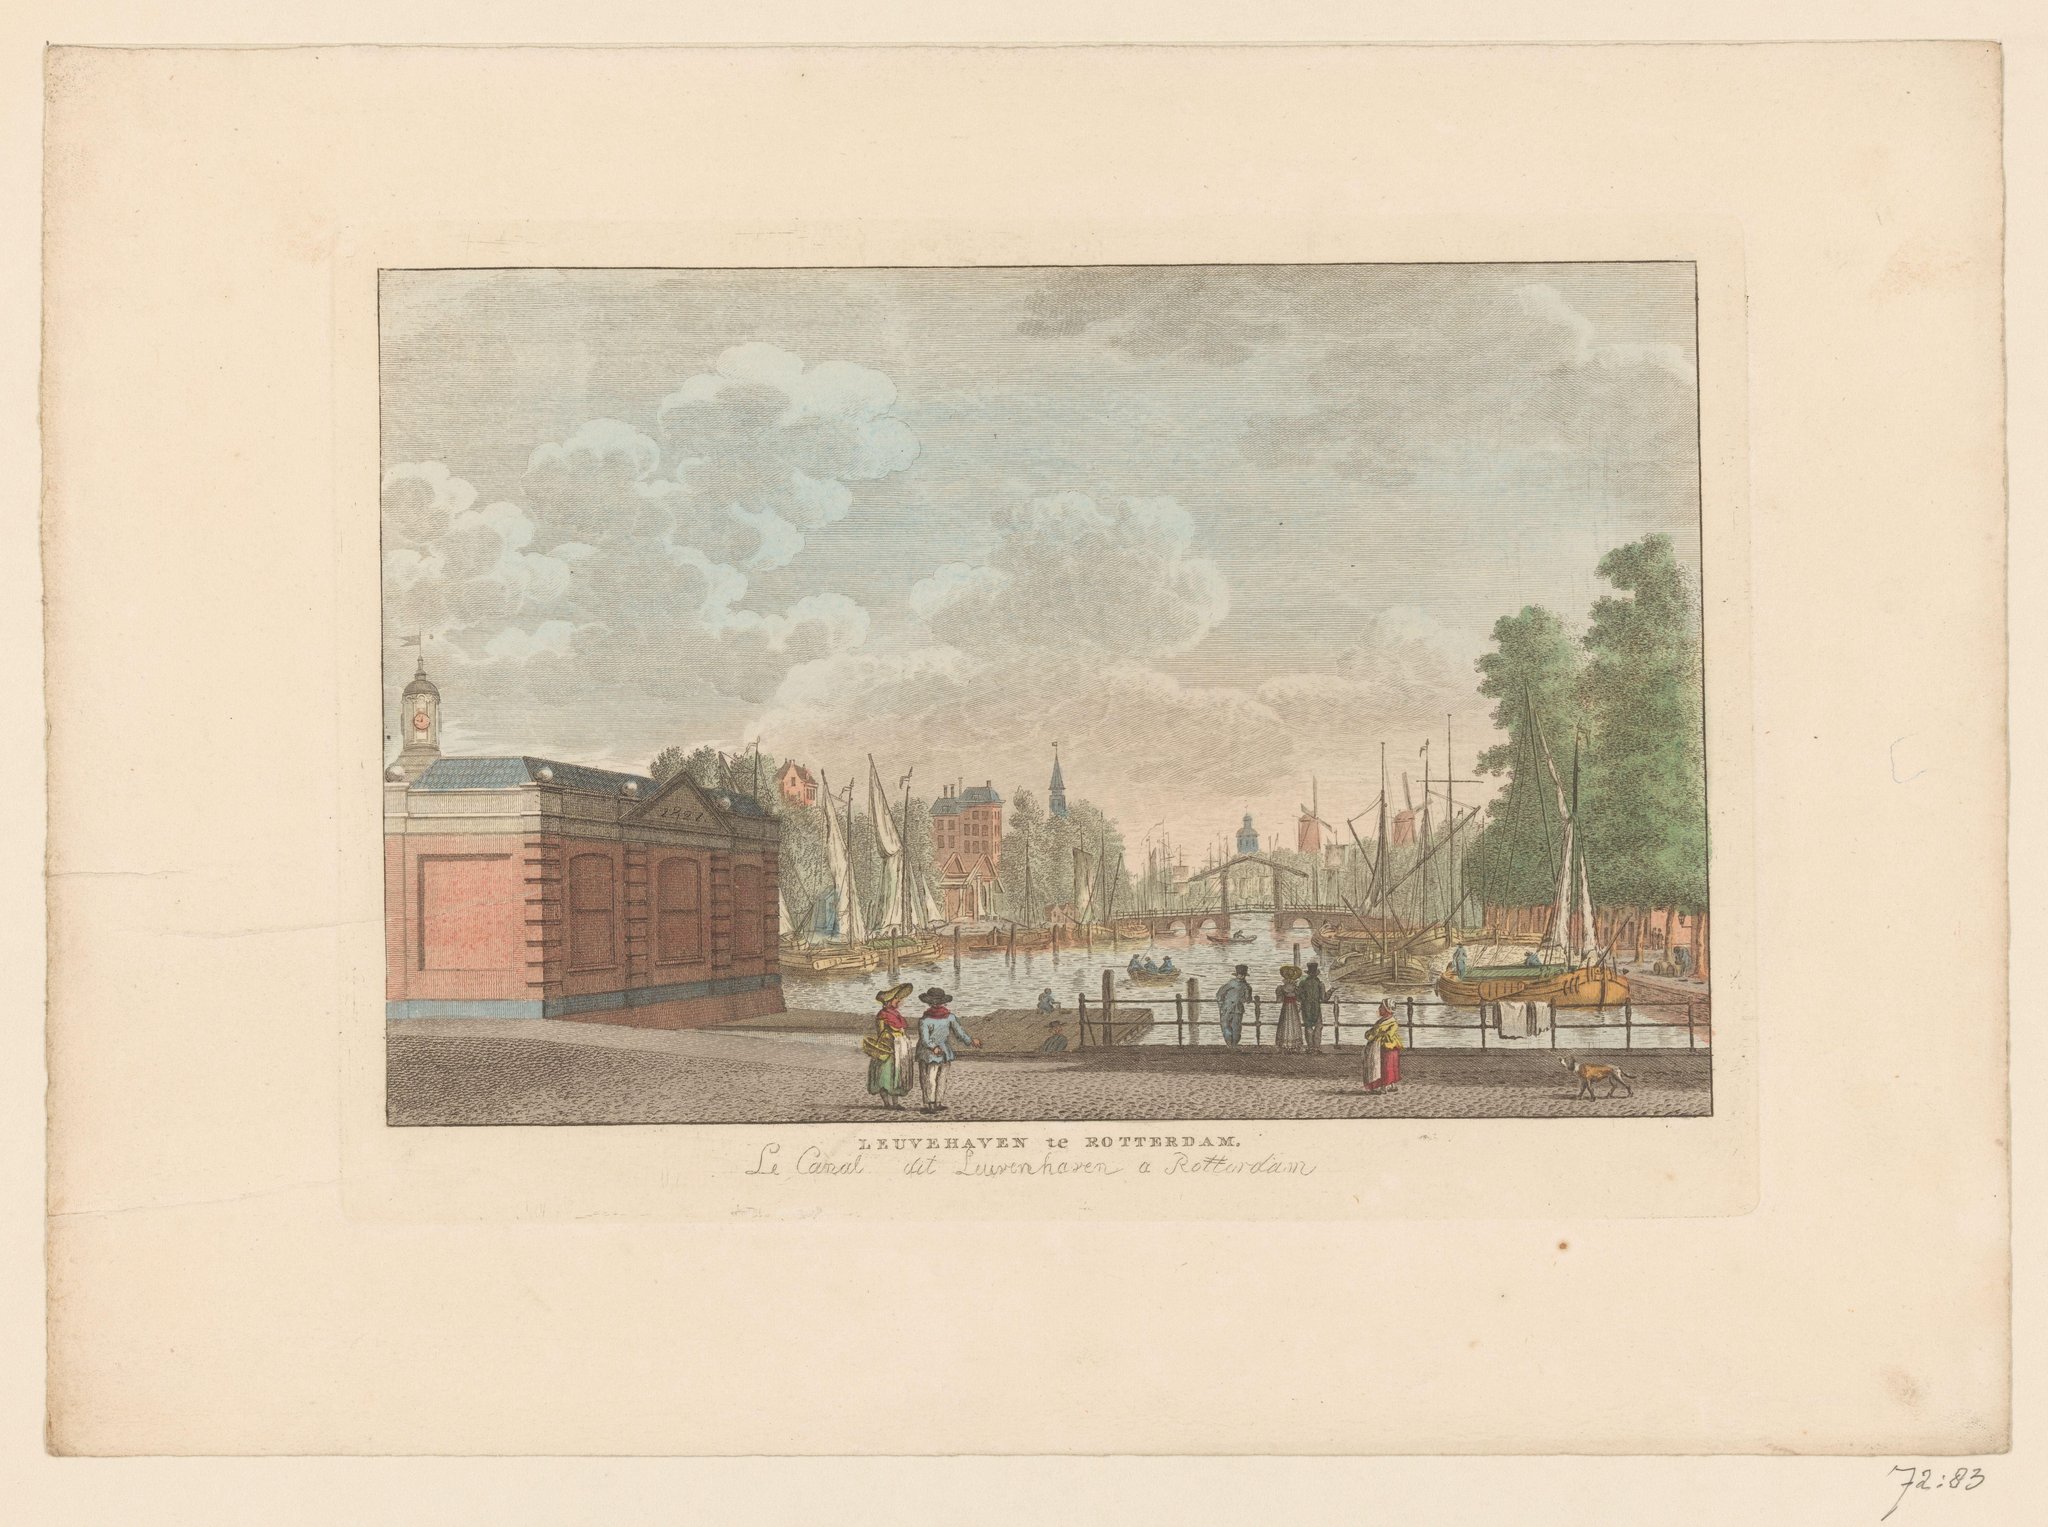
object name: print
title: Gezicht op de Leuvehaven in Rotterdam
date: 1786-1792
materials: paper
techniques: engraving, etching, hand coloring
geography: amsterdam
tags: sailing-ship, sailing-boat, bridge in city across river, canal, etc., prospect of city, town panorama, silhouette of city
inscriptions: collector's mark: Lugt 2228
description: Huidige staat van prent uitgegeven als onderdeel van een plaatwerk uit ca. 1824-1825 met 74 (ongenummerde) platen van de belangrijkste topografische gezichten en verschillende zeden en gewoonten in het Verenigd Koninkrijk der Nederlanden, getiteld 'Tableau des principales vues des palais et édifices : représentations et des coutumes et usages, dans les provinces septentrionales du Royaume des Pays-Bas'. Eerdere staat gebruikt in: Vaderlandsche gezichten, of afbeeldingen van den tegenwoordigen staat der Vereenigde Nederlanden (…). Amsterdam: Hendrik Gartman, Willem Vermandel en Jan Willem Smit, 1786-1792. Uitgegeven in afleveringen met ieder een eigen bifolium en inhoudsopgave. Alle prenten in deze publicatie zijn gegraveerd door Carel Frederik Bendorp (I) en, in de meeste gevallen, gebaseerd op tekeningen van Jan Bulthuis.